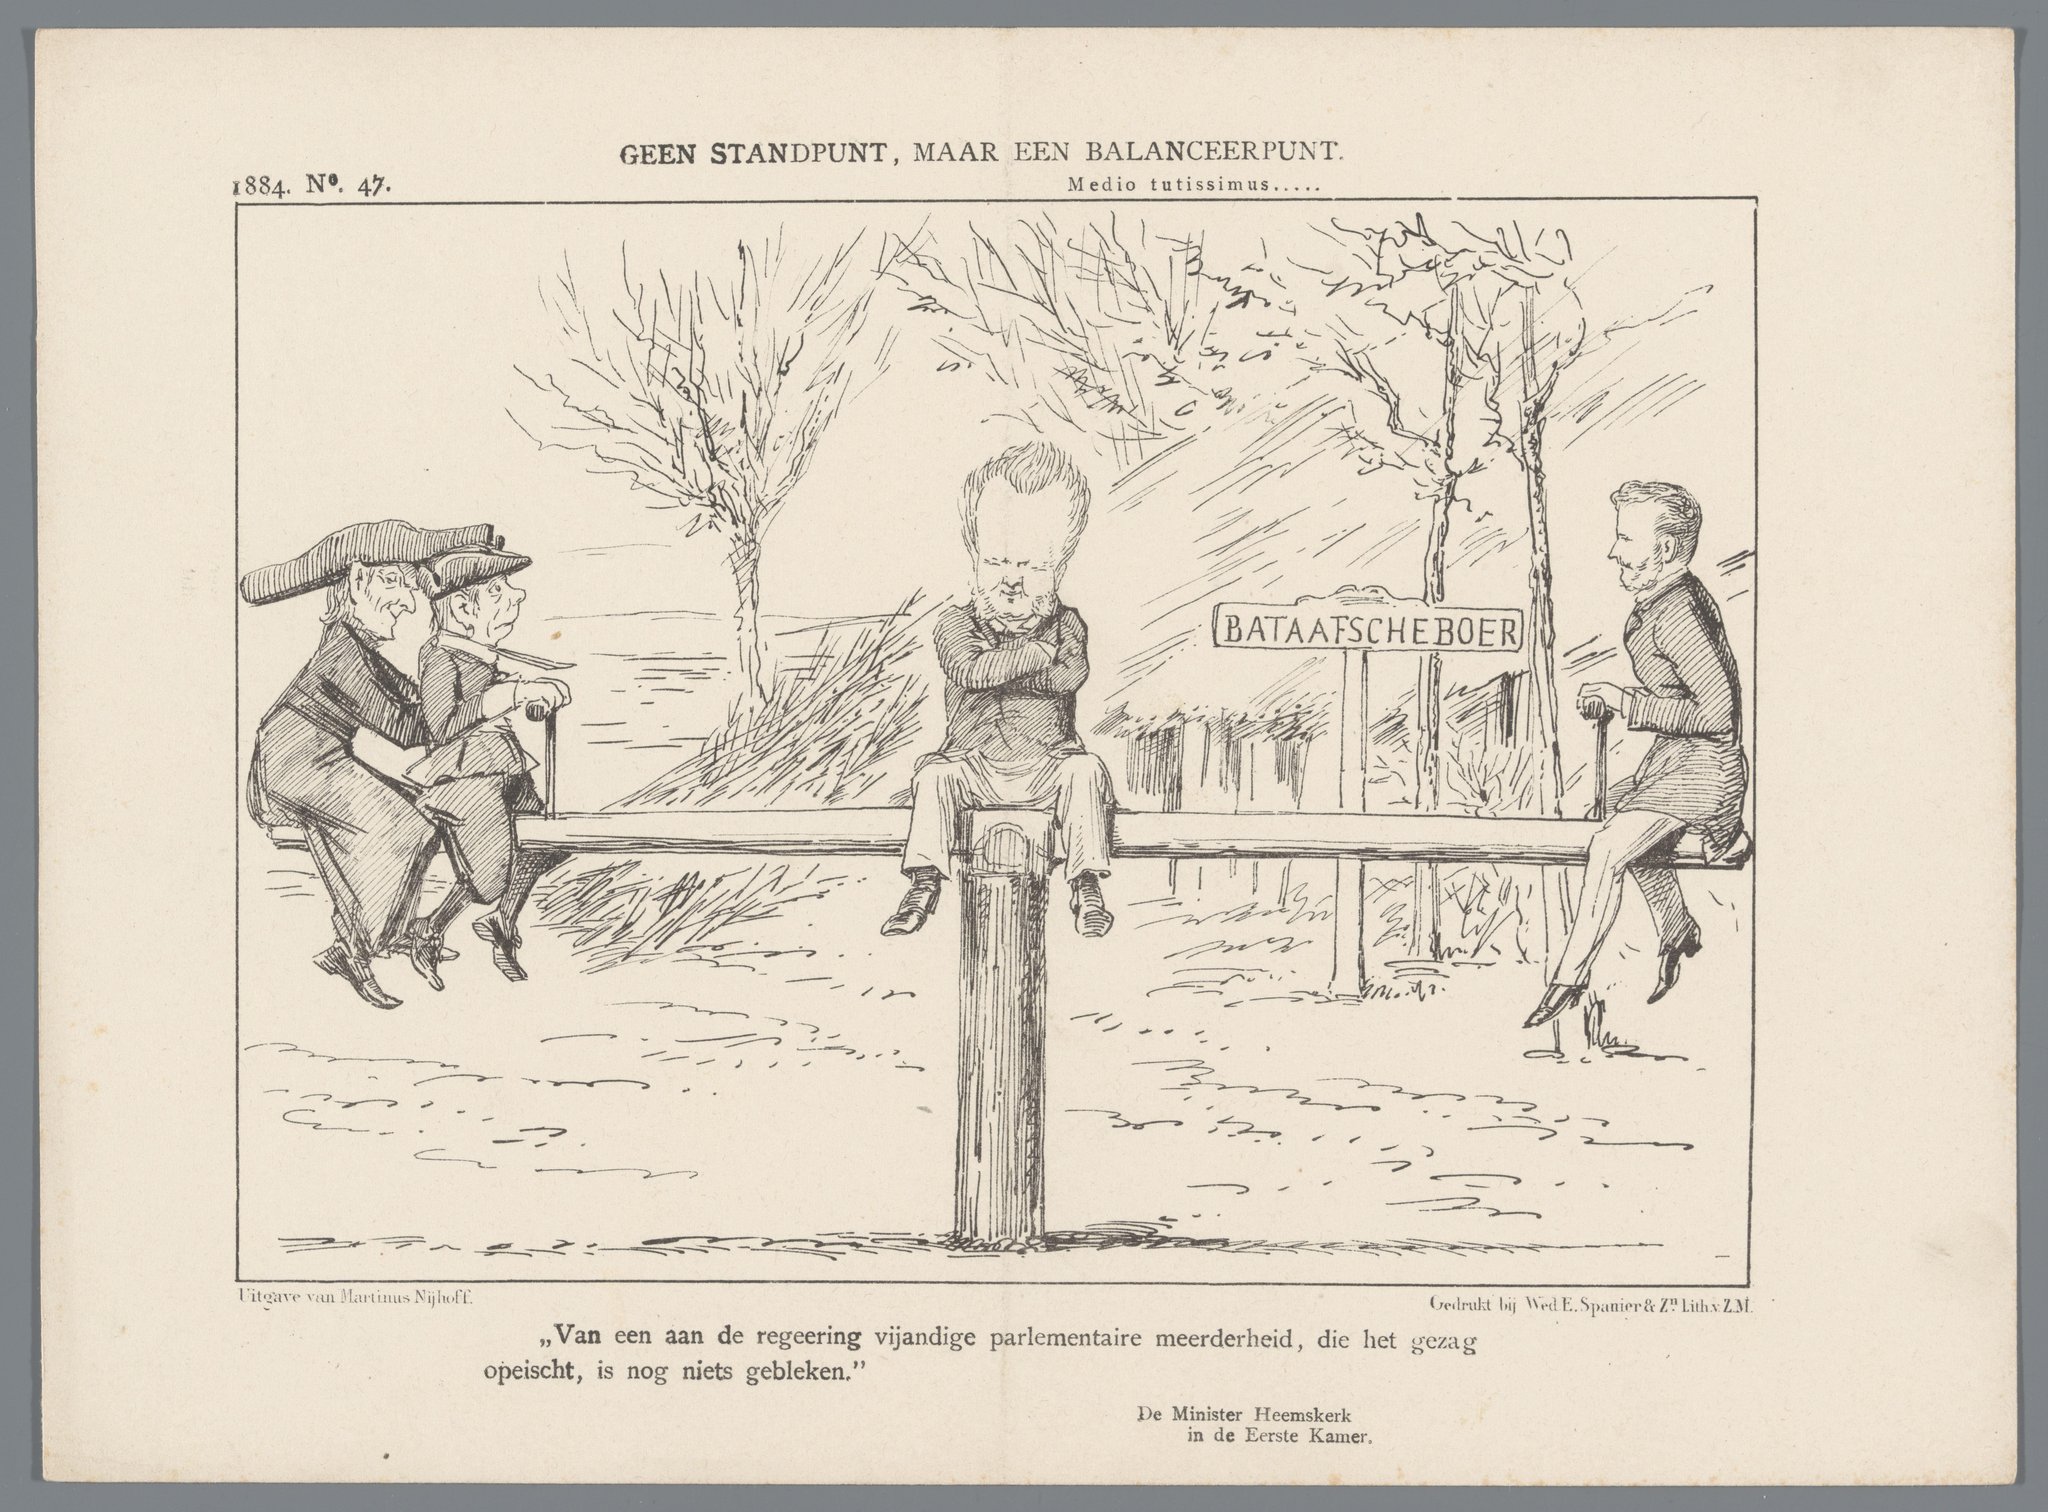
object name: cartoon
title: Geen standpunt, maar een balanceerpunt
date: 1884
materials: paper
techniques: lithograph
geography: the hague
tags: seesaw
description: Spotprent met minister Heemskerk zittend op het midden van de wip. Plaat verschenen bij het weekblad De Nederlandsche Spectator, nr. 47, 1884.